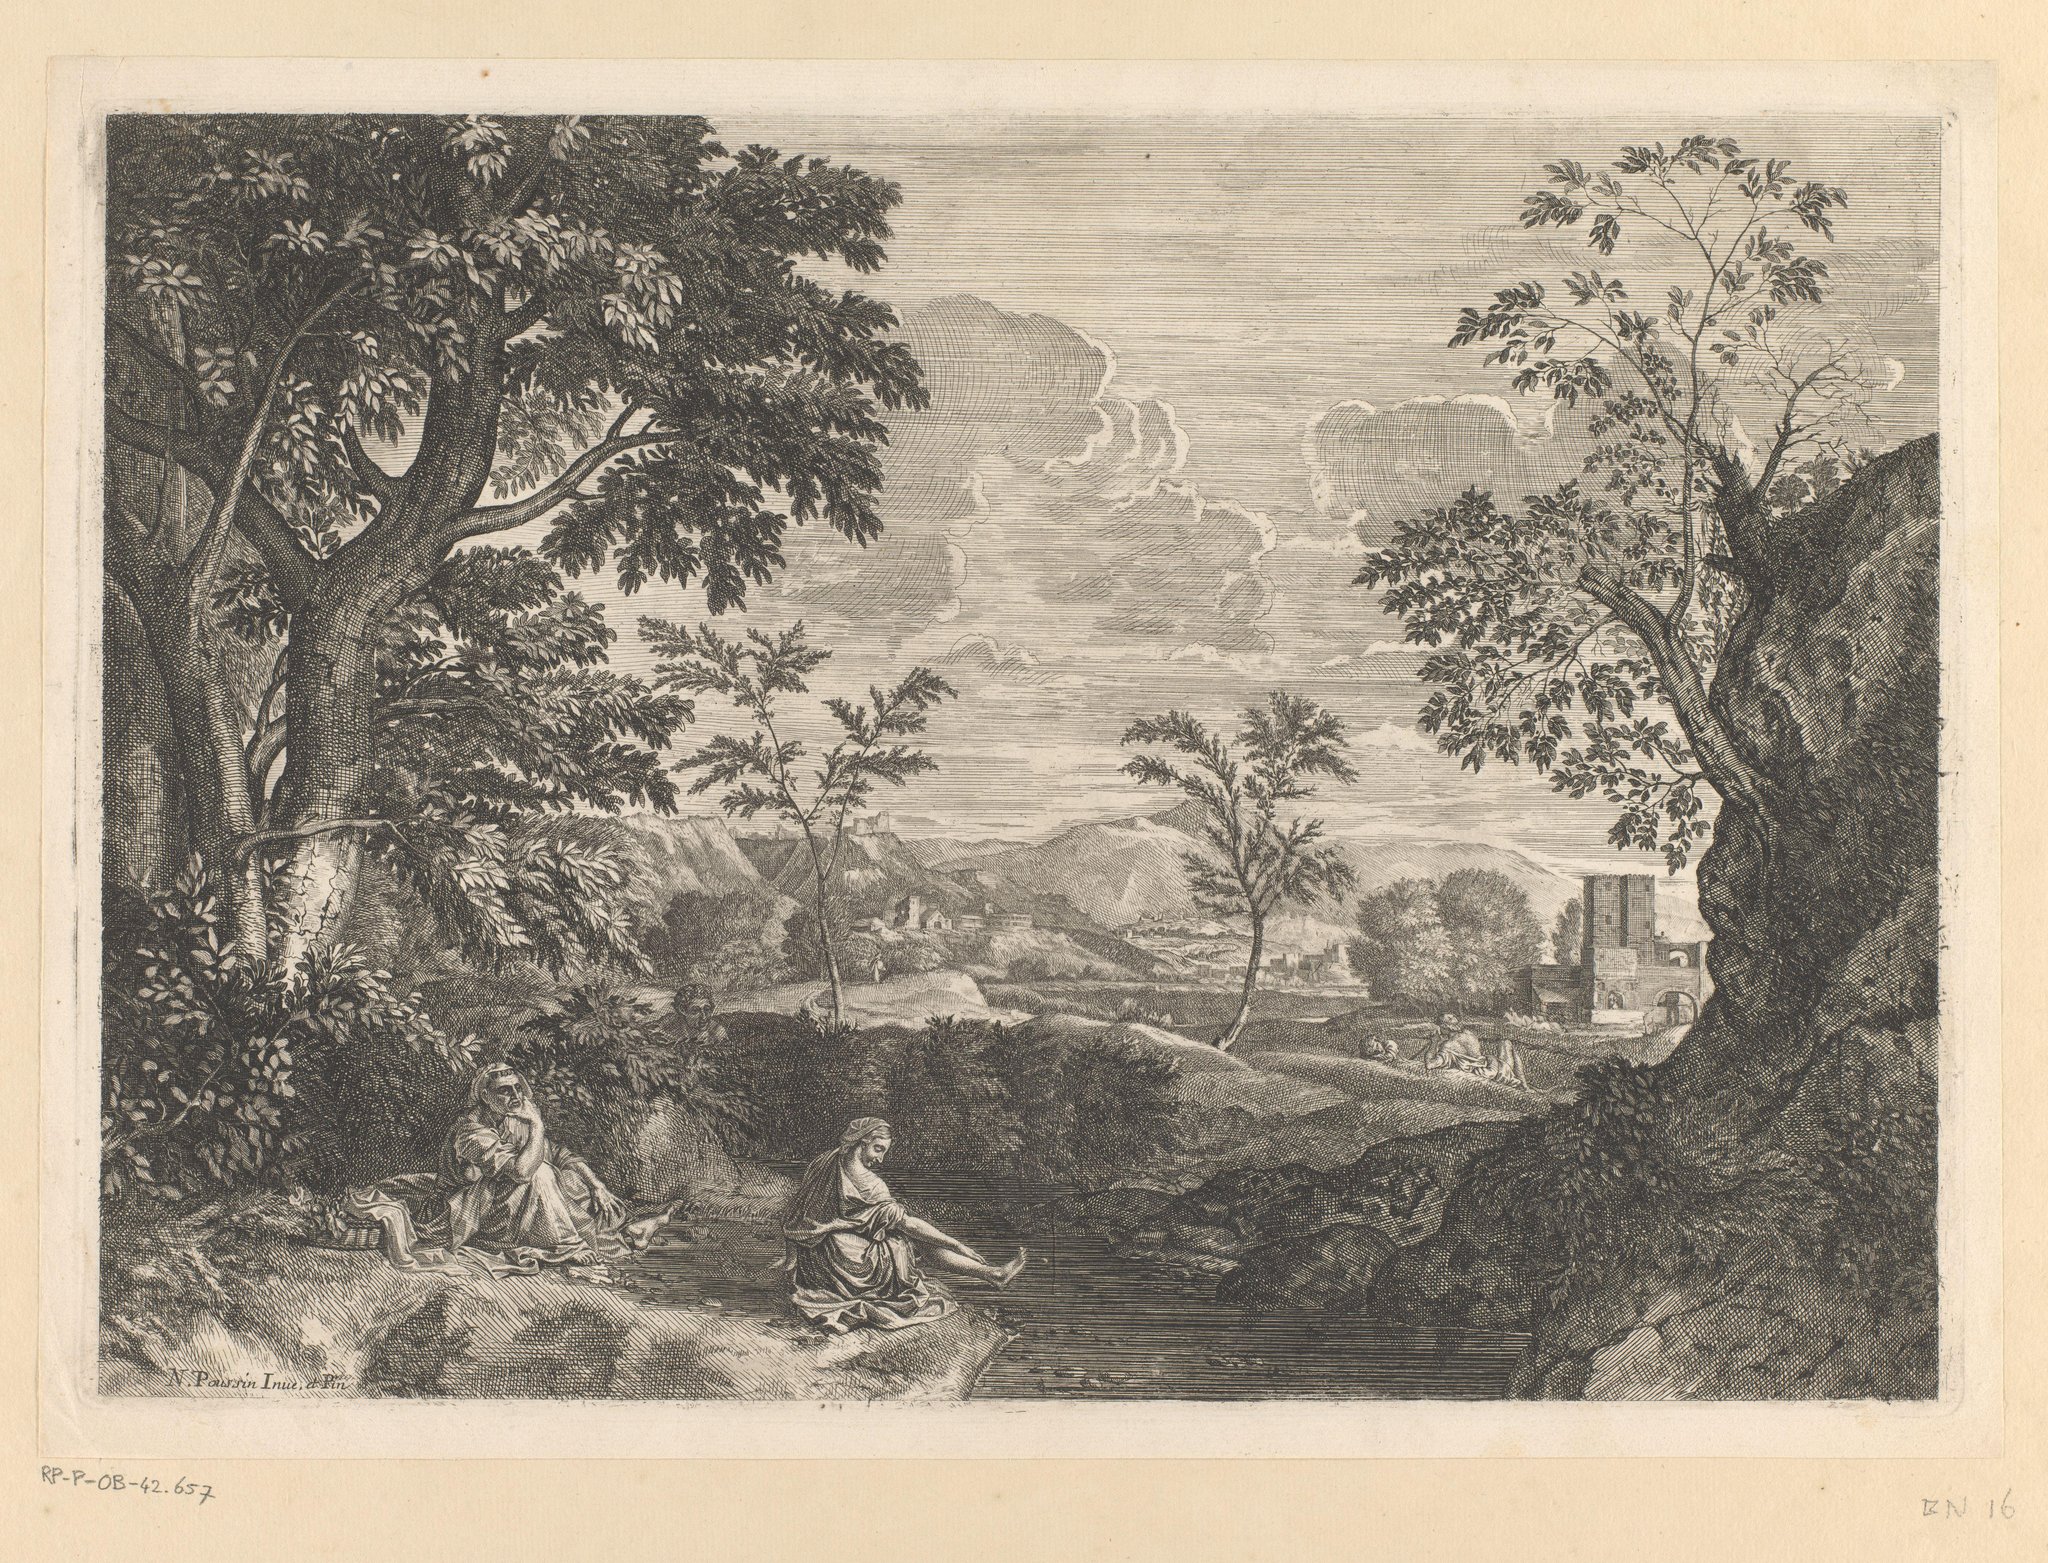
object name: print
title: Suite de six Paysages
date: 1649-1734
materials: paper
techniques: etching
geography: france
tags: landscapes with waters, waterscapes, seascapes (in the temperate zone), washing one's feet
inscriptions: collector's mark: Lugt 240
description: Maakt deel uit van een zesdelige serie met landschappen.